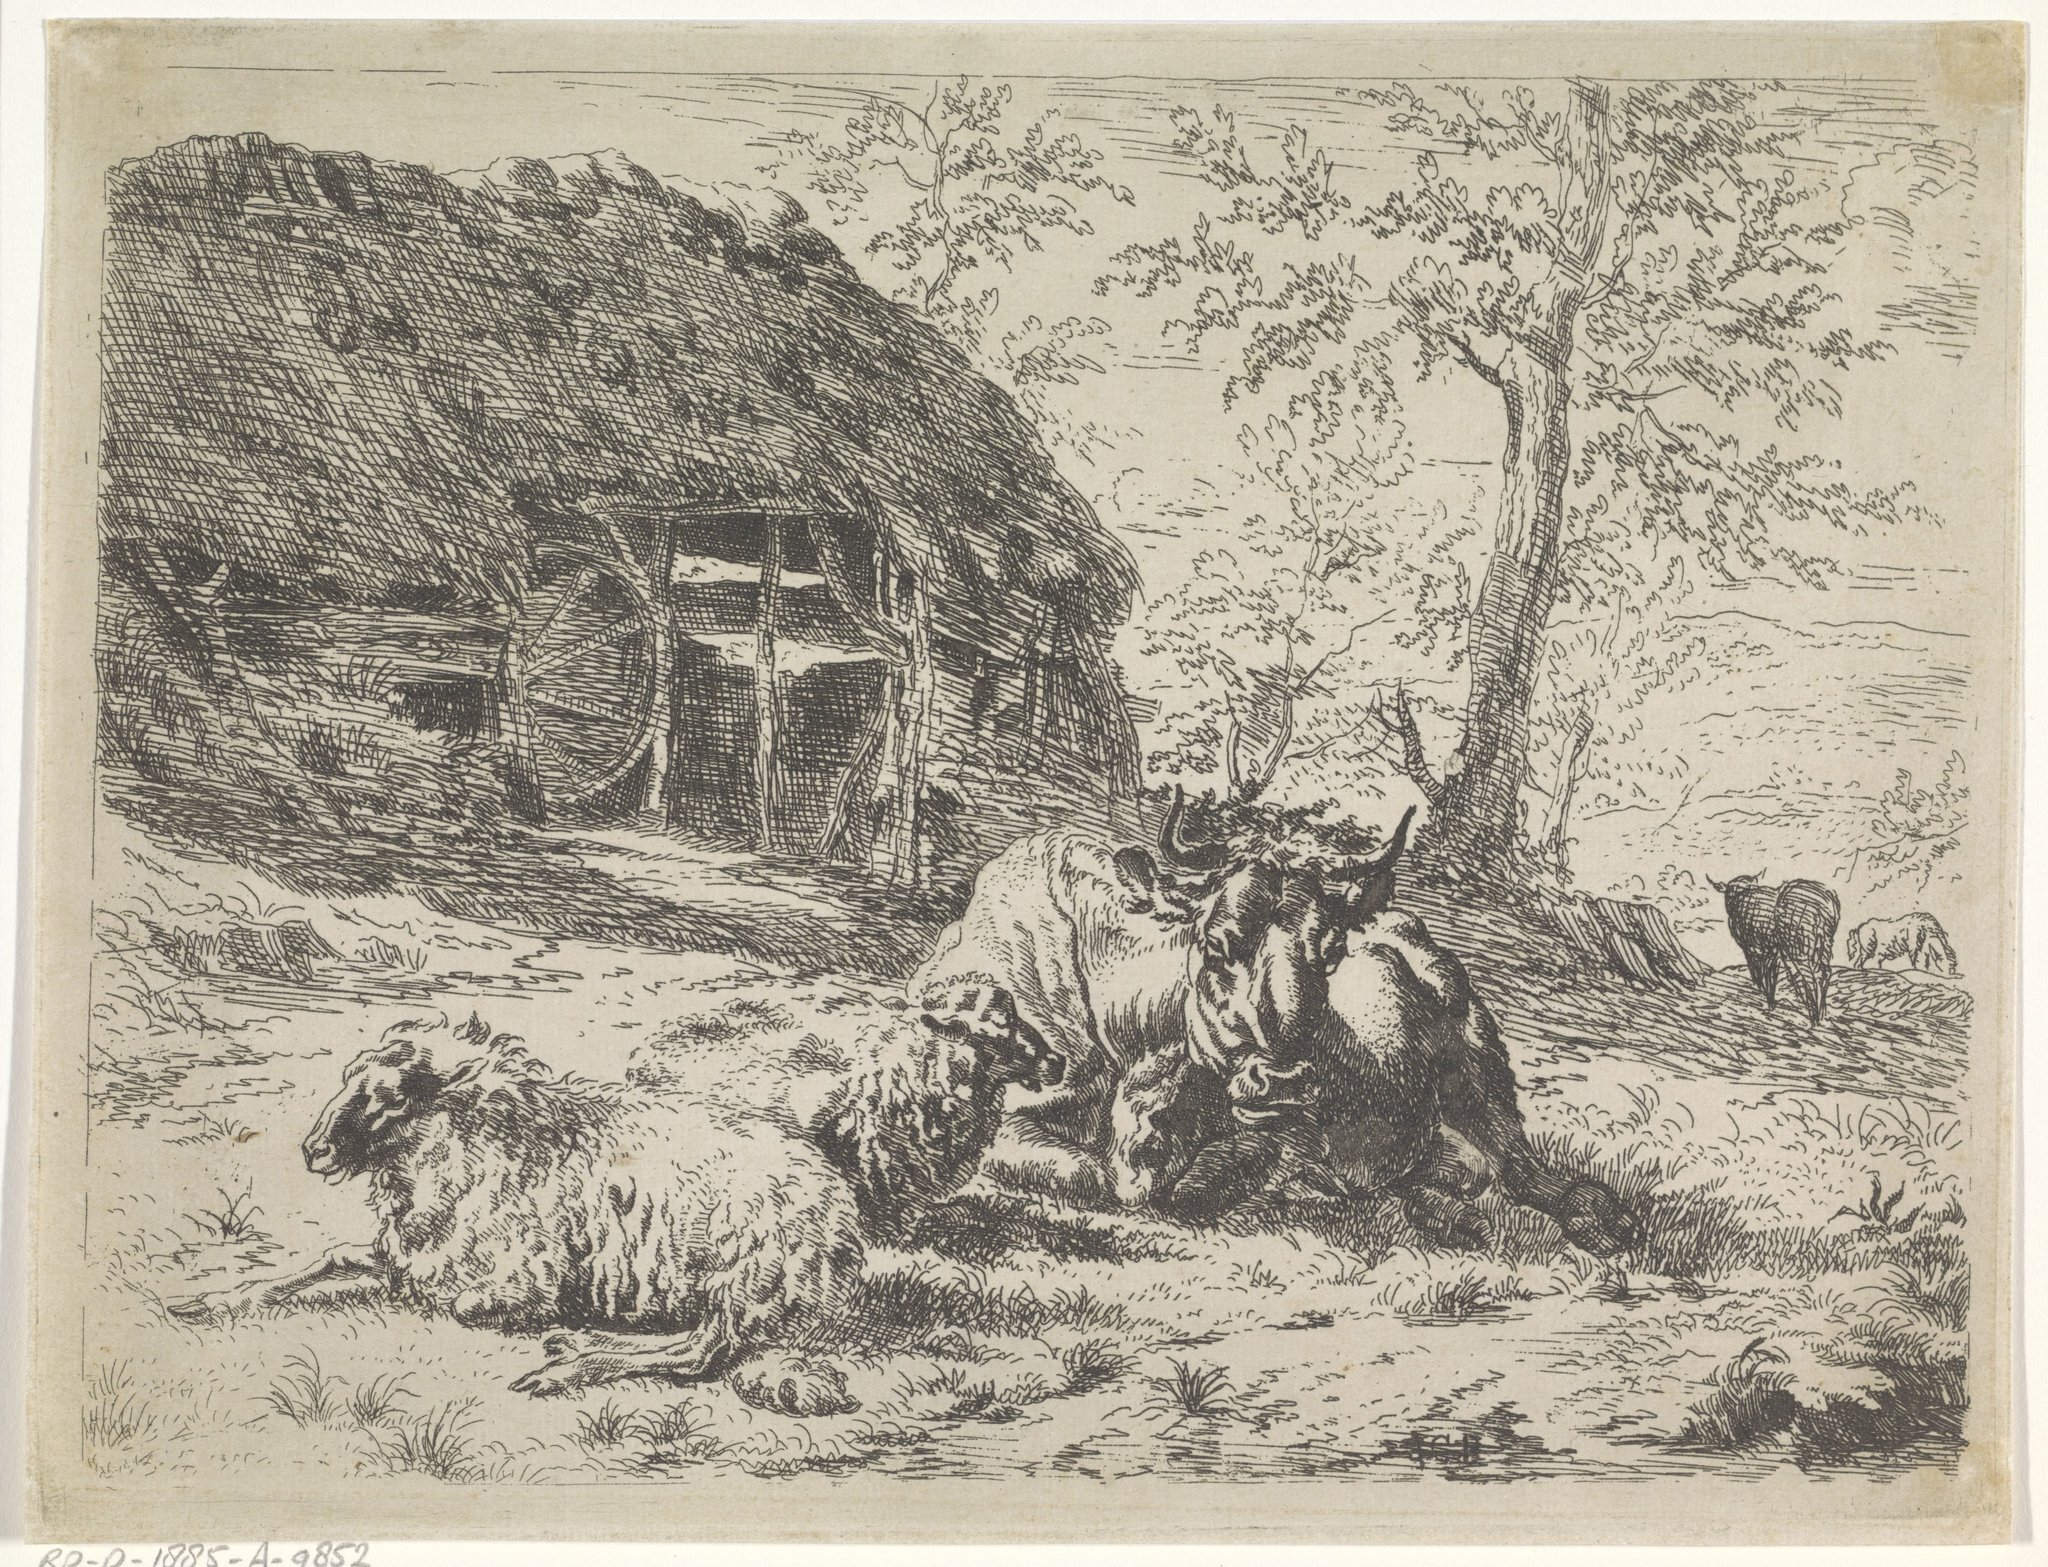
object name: print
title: Liggende koe en twee schapen bij een schuur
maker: monogrammist cb of icb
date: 1800-1885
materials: paper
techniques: etching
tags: barn, cow, sheep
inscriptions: collector's mark: Lugt 2228